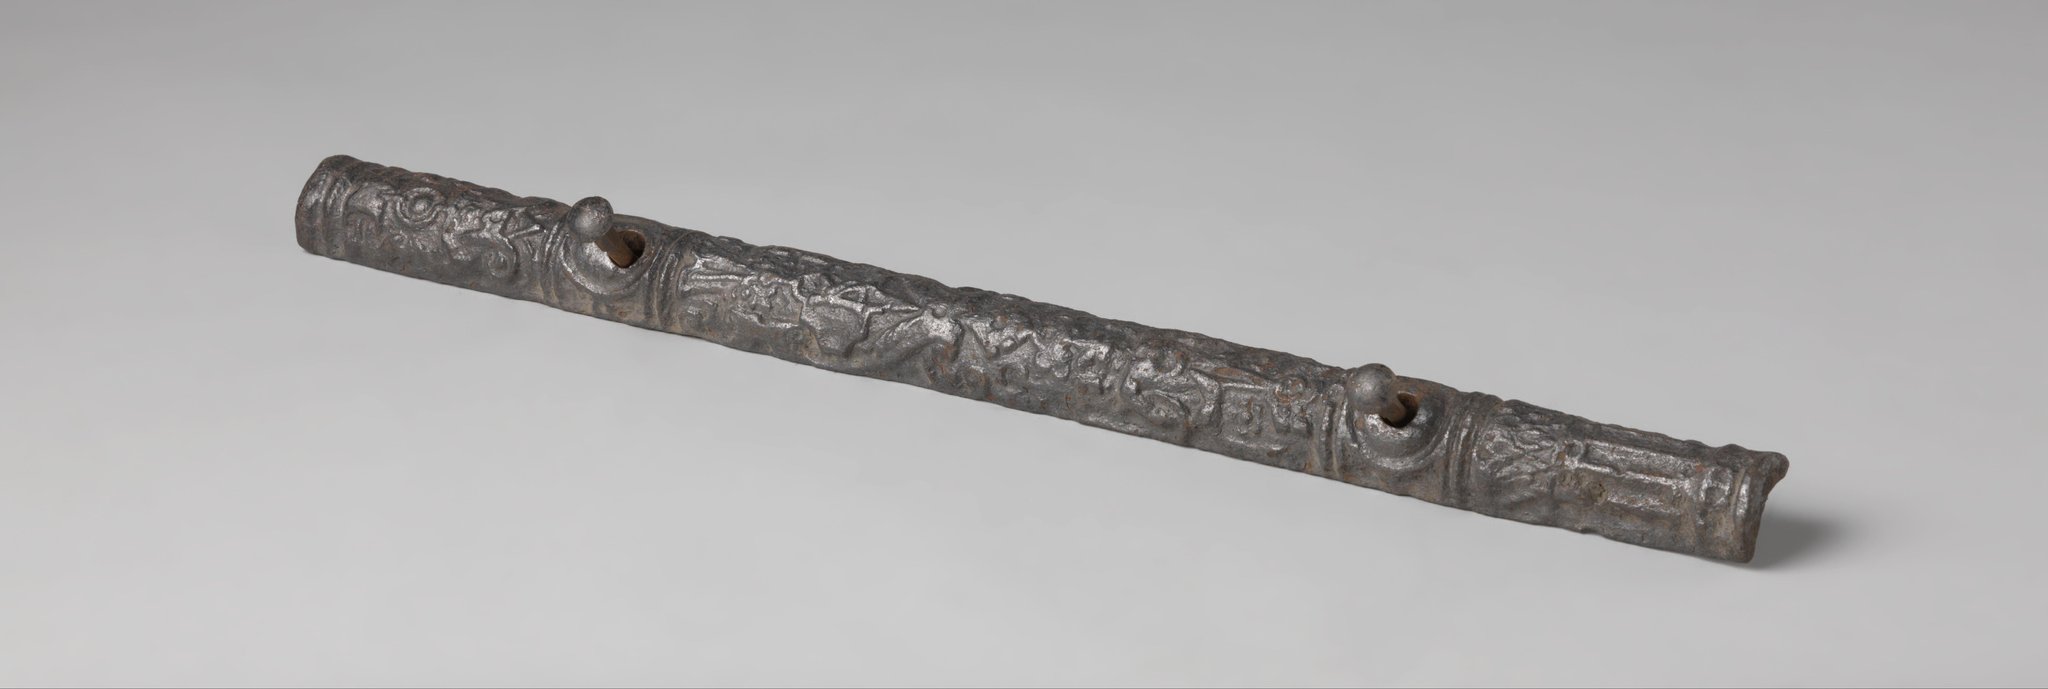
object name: stove component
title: Hoekdeel van een kachel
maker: Anonymous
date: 1660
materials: iron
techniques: casting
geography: germany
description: Gietijzeren hoekdeel van een kachel. Gedecoreerd met een leeuwenkop en andere motieven.